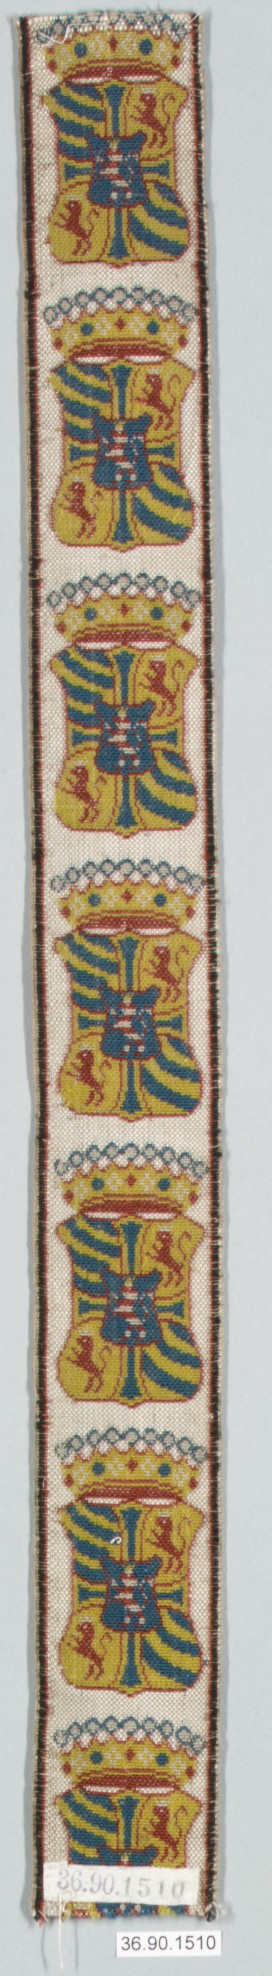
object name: galloon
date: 1701-1900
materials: silk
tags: coat of arms